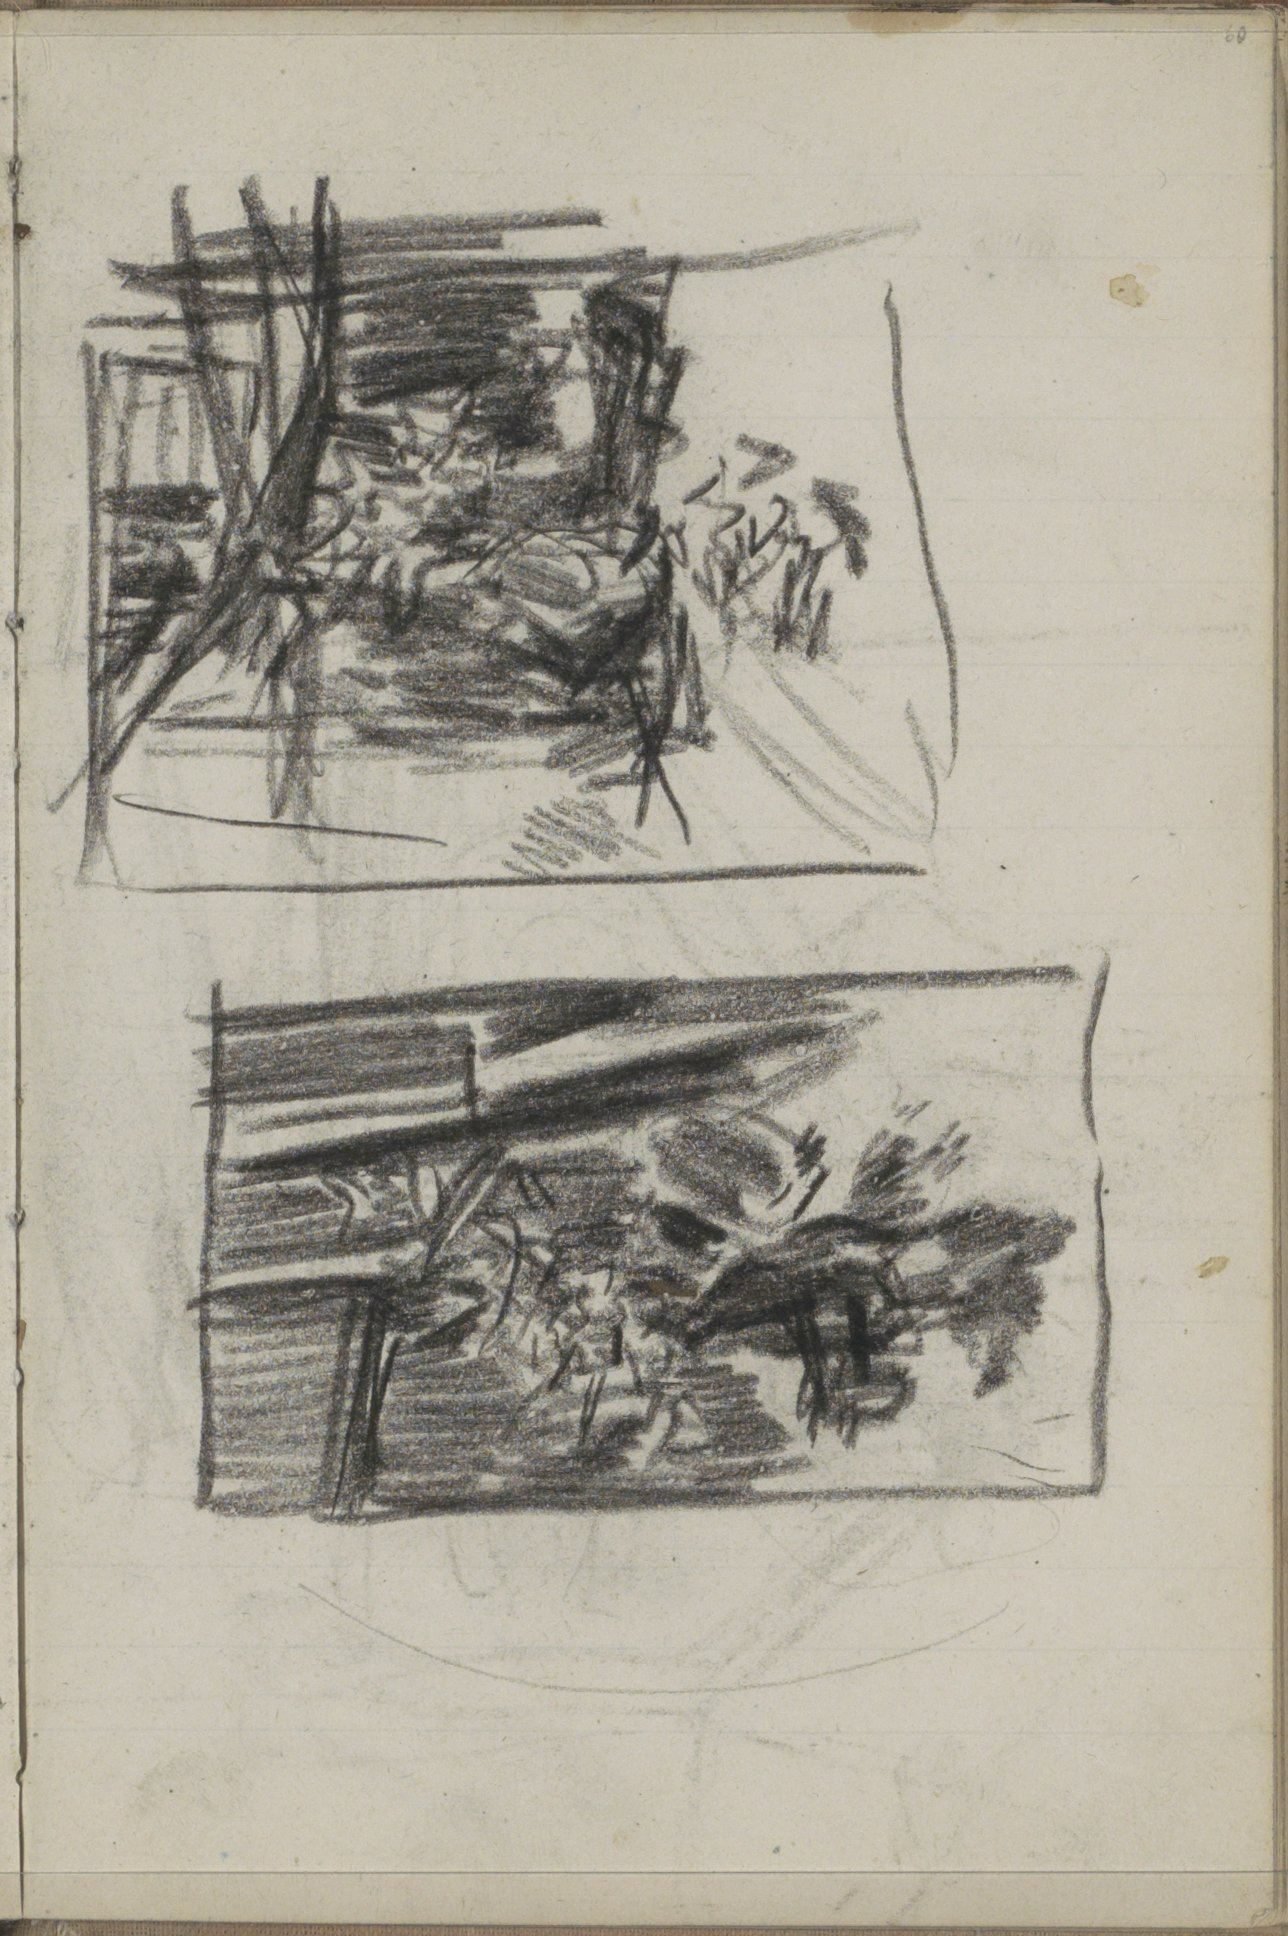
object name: sketchbook leaf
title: Studies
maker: marius bauer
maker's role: draughtsman, print maker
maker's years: 1867-1932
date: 1888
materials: chalk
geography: istanbul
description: Pagina 68 uit een schetsboek met 58 bladen.